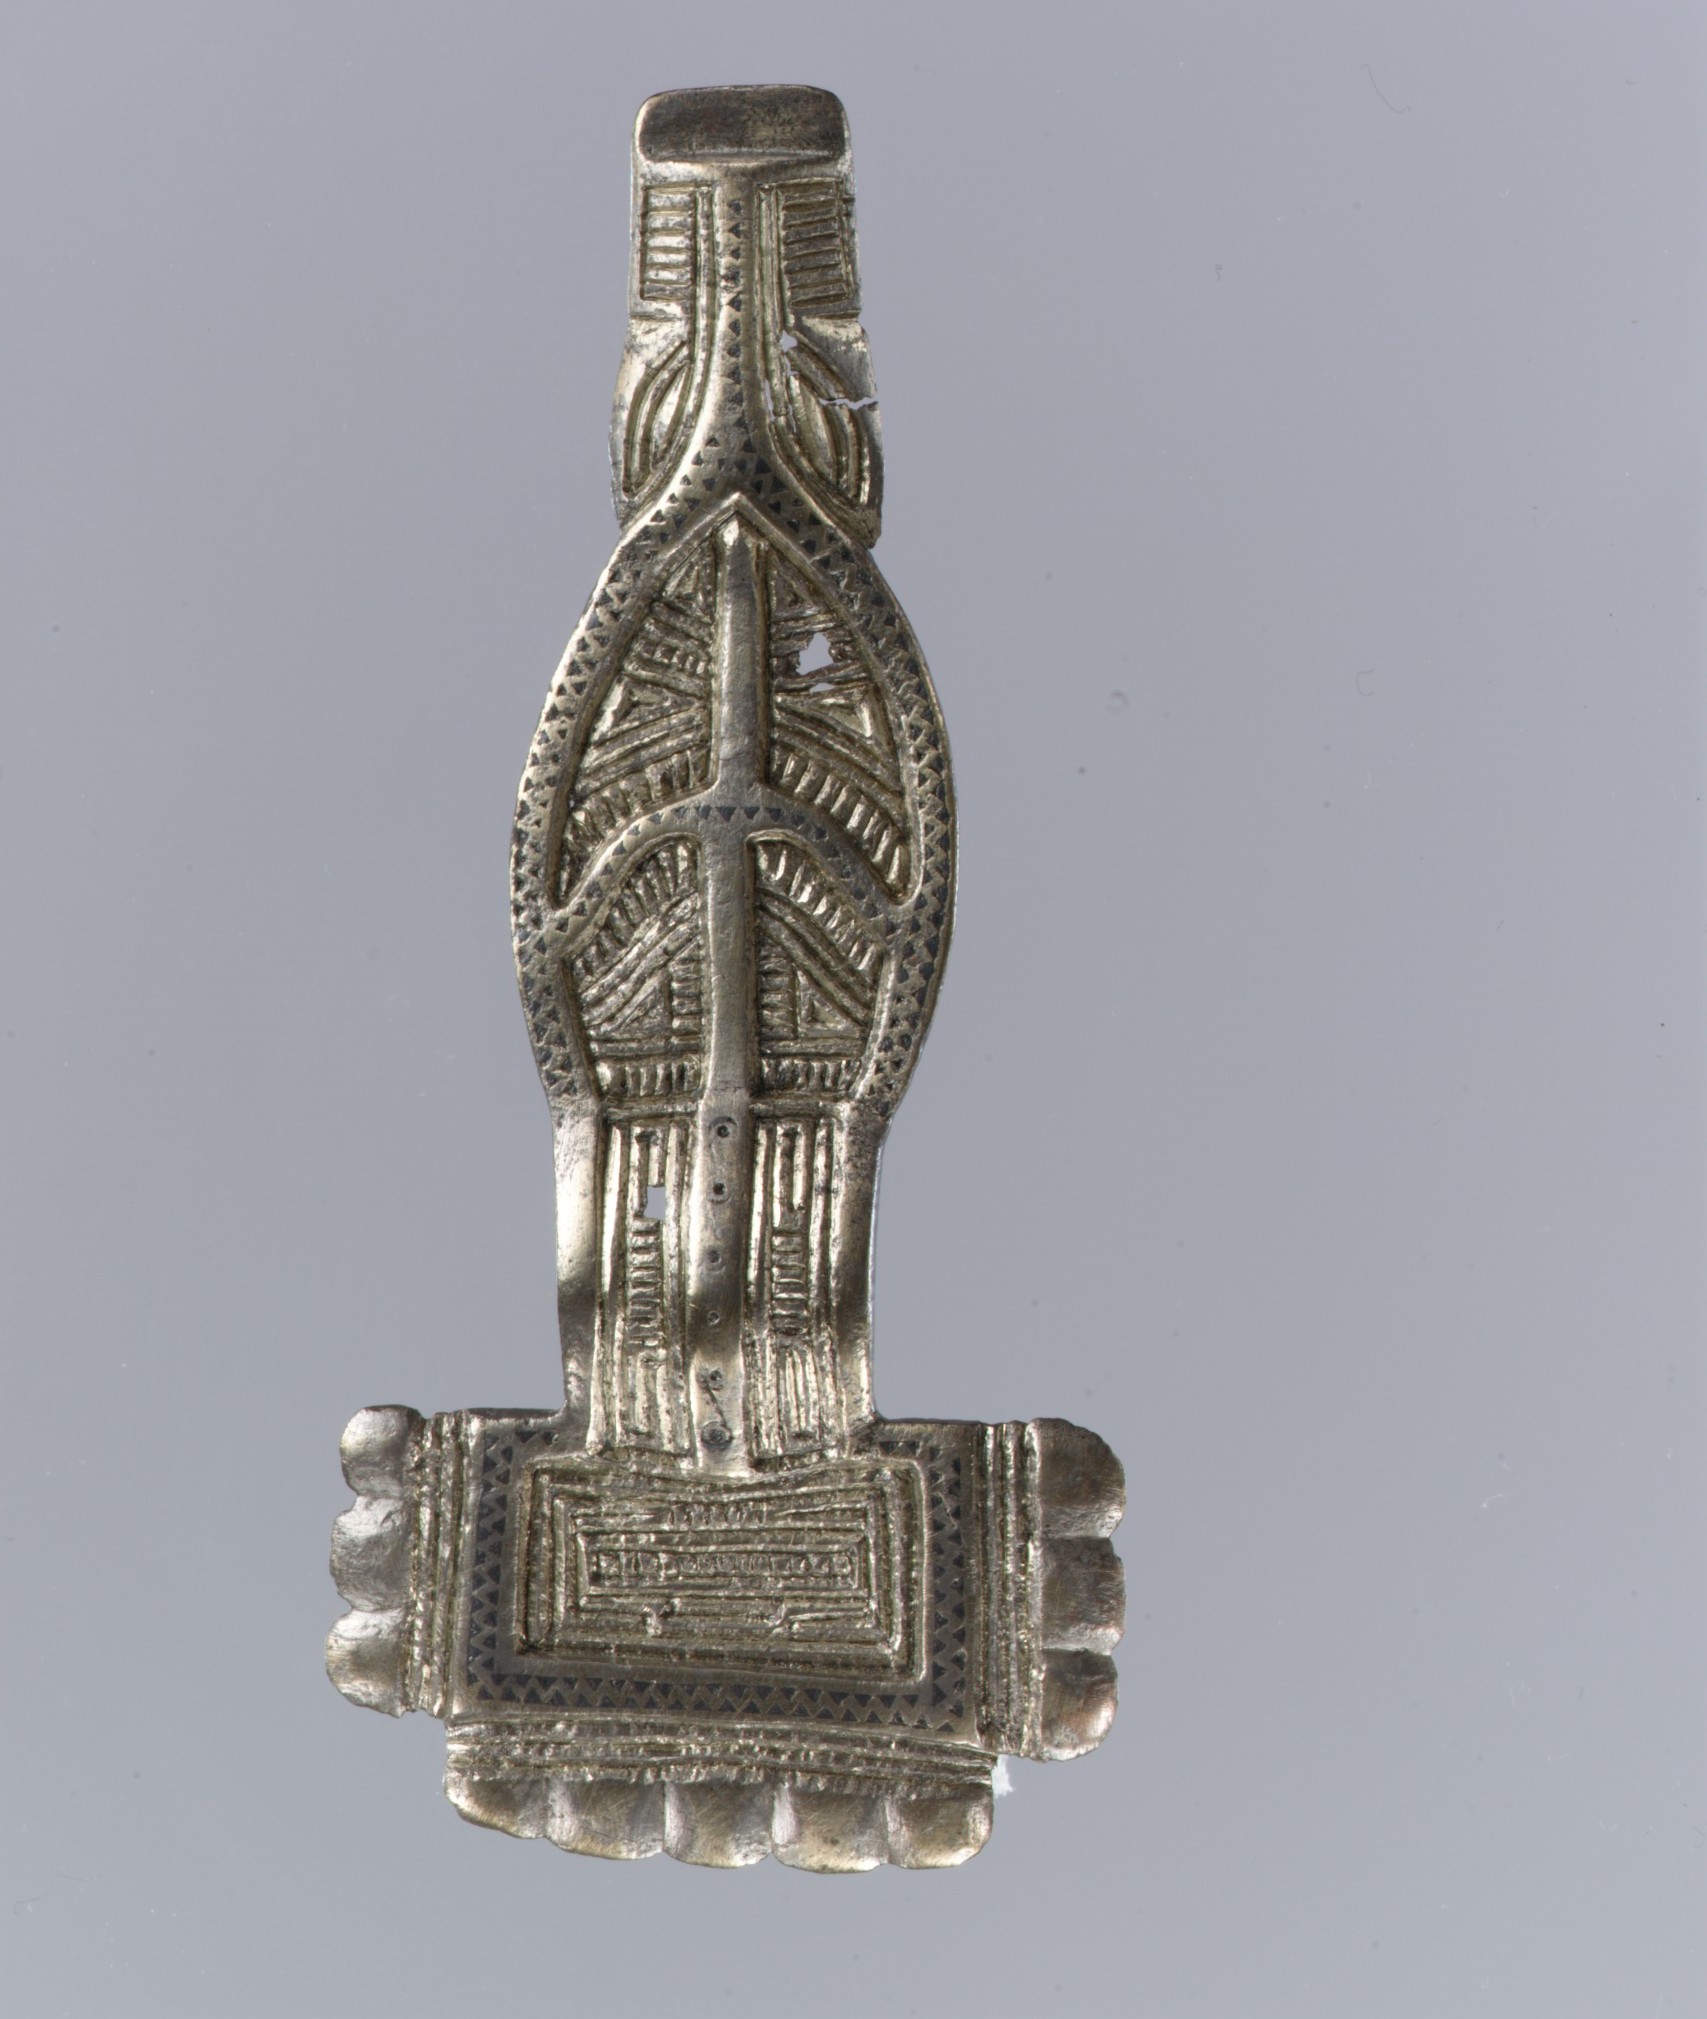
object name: brooch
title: Square-Headed Bow Brooch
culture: frankish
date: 551-600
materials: niello, silver gilt